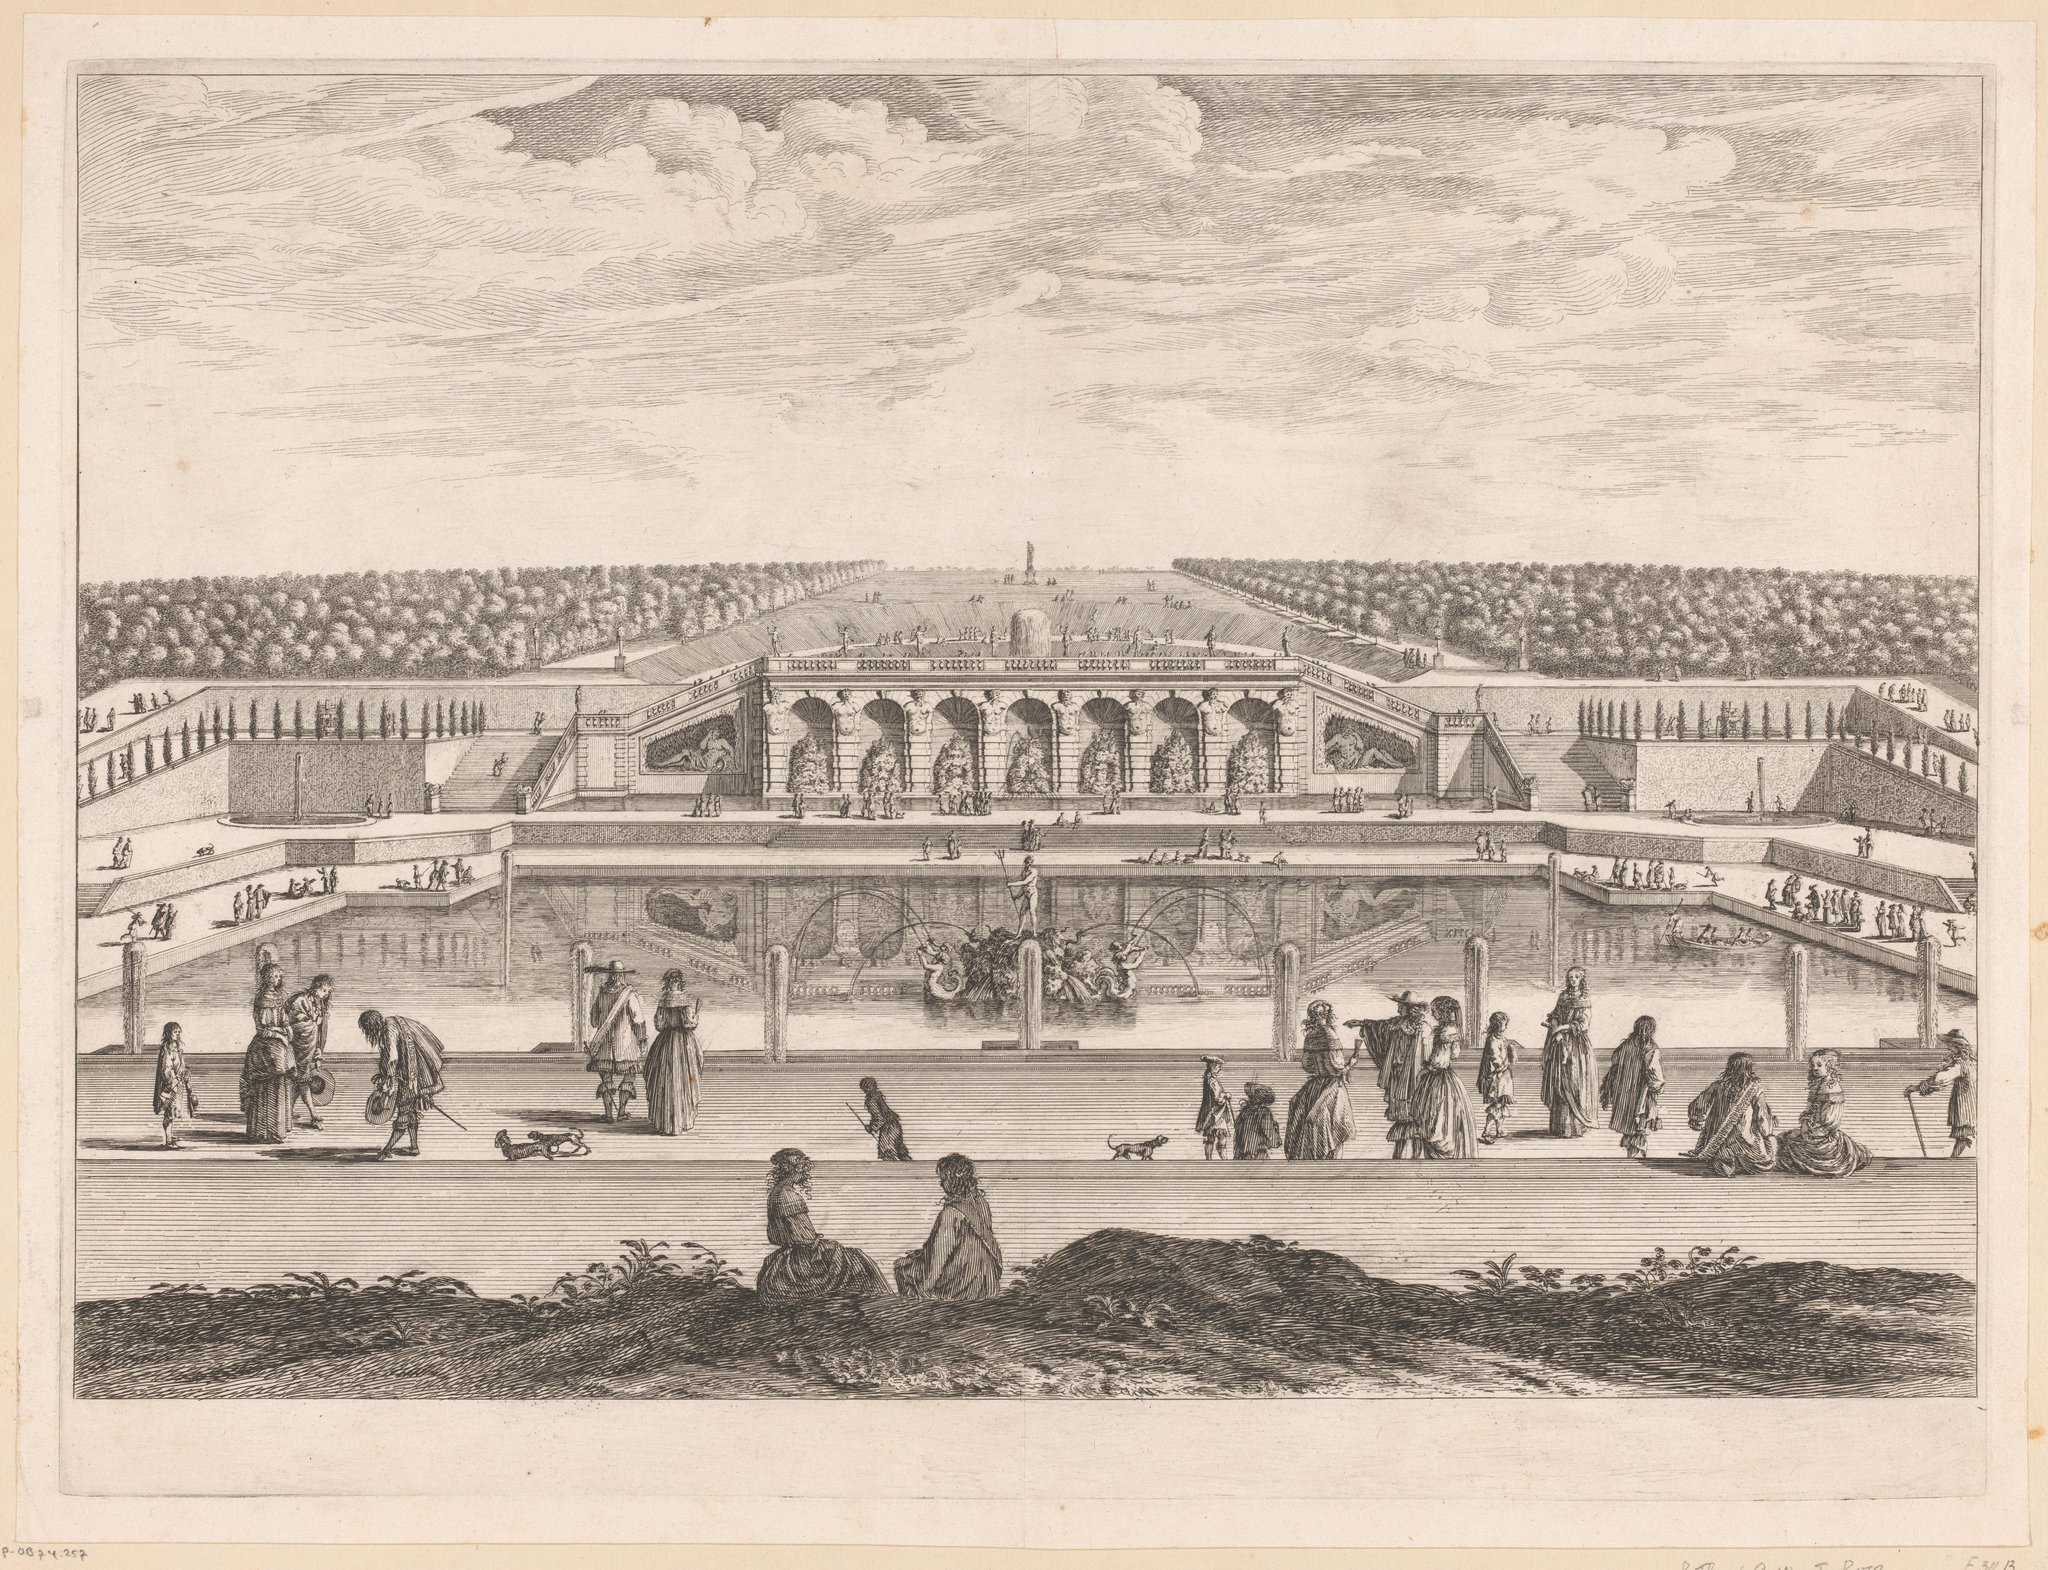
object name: print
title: Gezicht op de tuinen van Vaux-le-Vicomte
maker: israël silvestre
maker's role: draughtsman, print maker, publisher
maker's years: 1621-1691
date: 1631-1691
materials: paper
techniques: etching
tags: garden fountain, french or architectonic garden; formal garden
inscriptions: collector's mark: Lugt 240